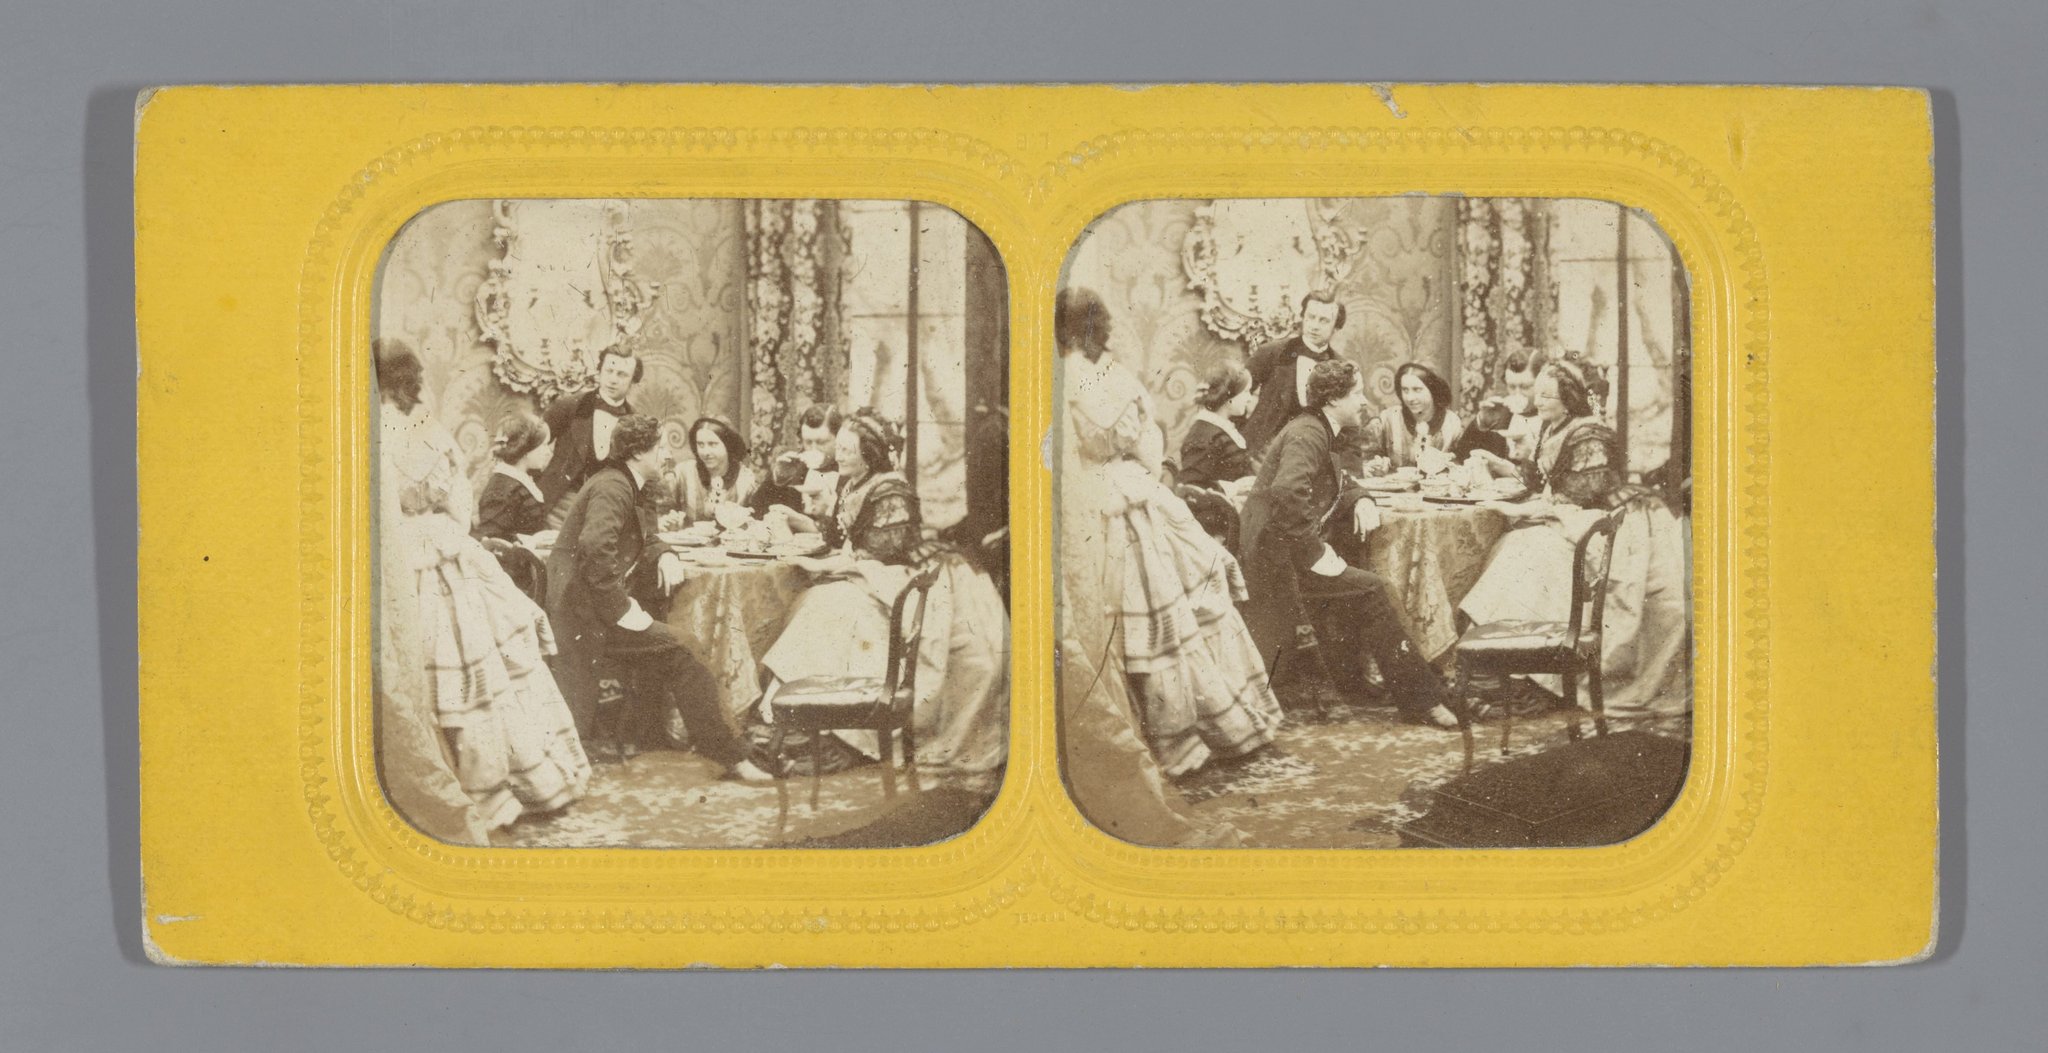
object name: tissue stereograph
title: Theedrinkend gezelschap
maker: l.b. (fotograaf)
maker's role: fotograaf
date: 1855-1875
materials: cardboard, paper, photographic support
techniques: albumen print, hand coloring, perforating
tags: cup of tea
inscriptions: inscription: ‘D. 1’, inscription: ‘DEPOSÉ’, number: ‘No 12’